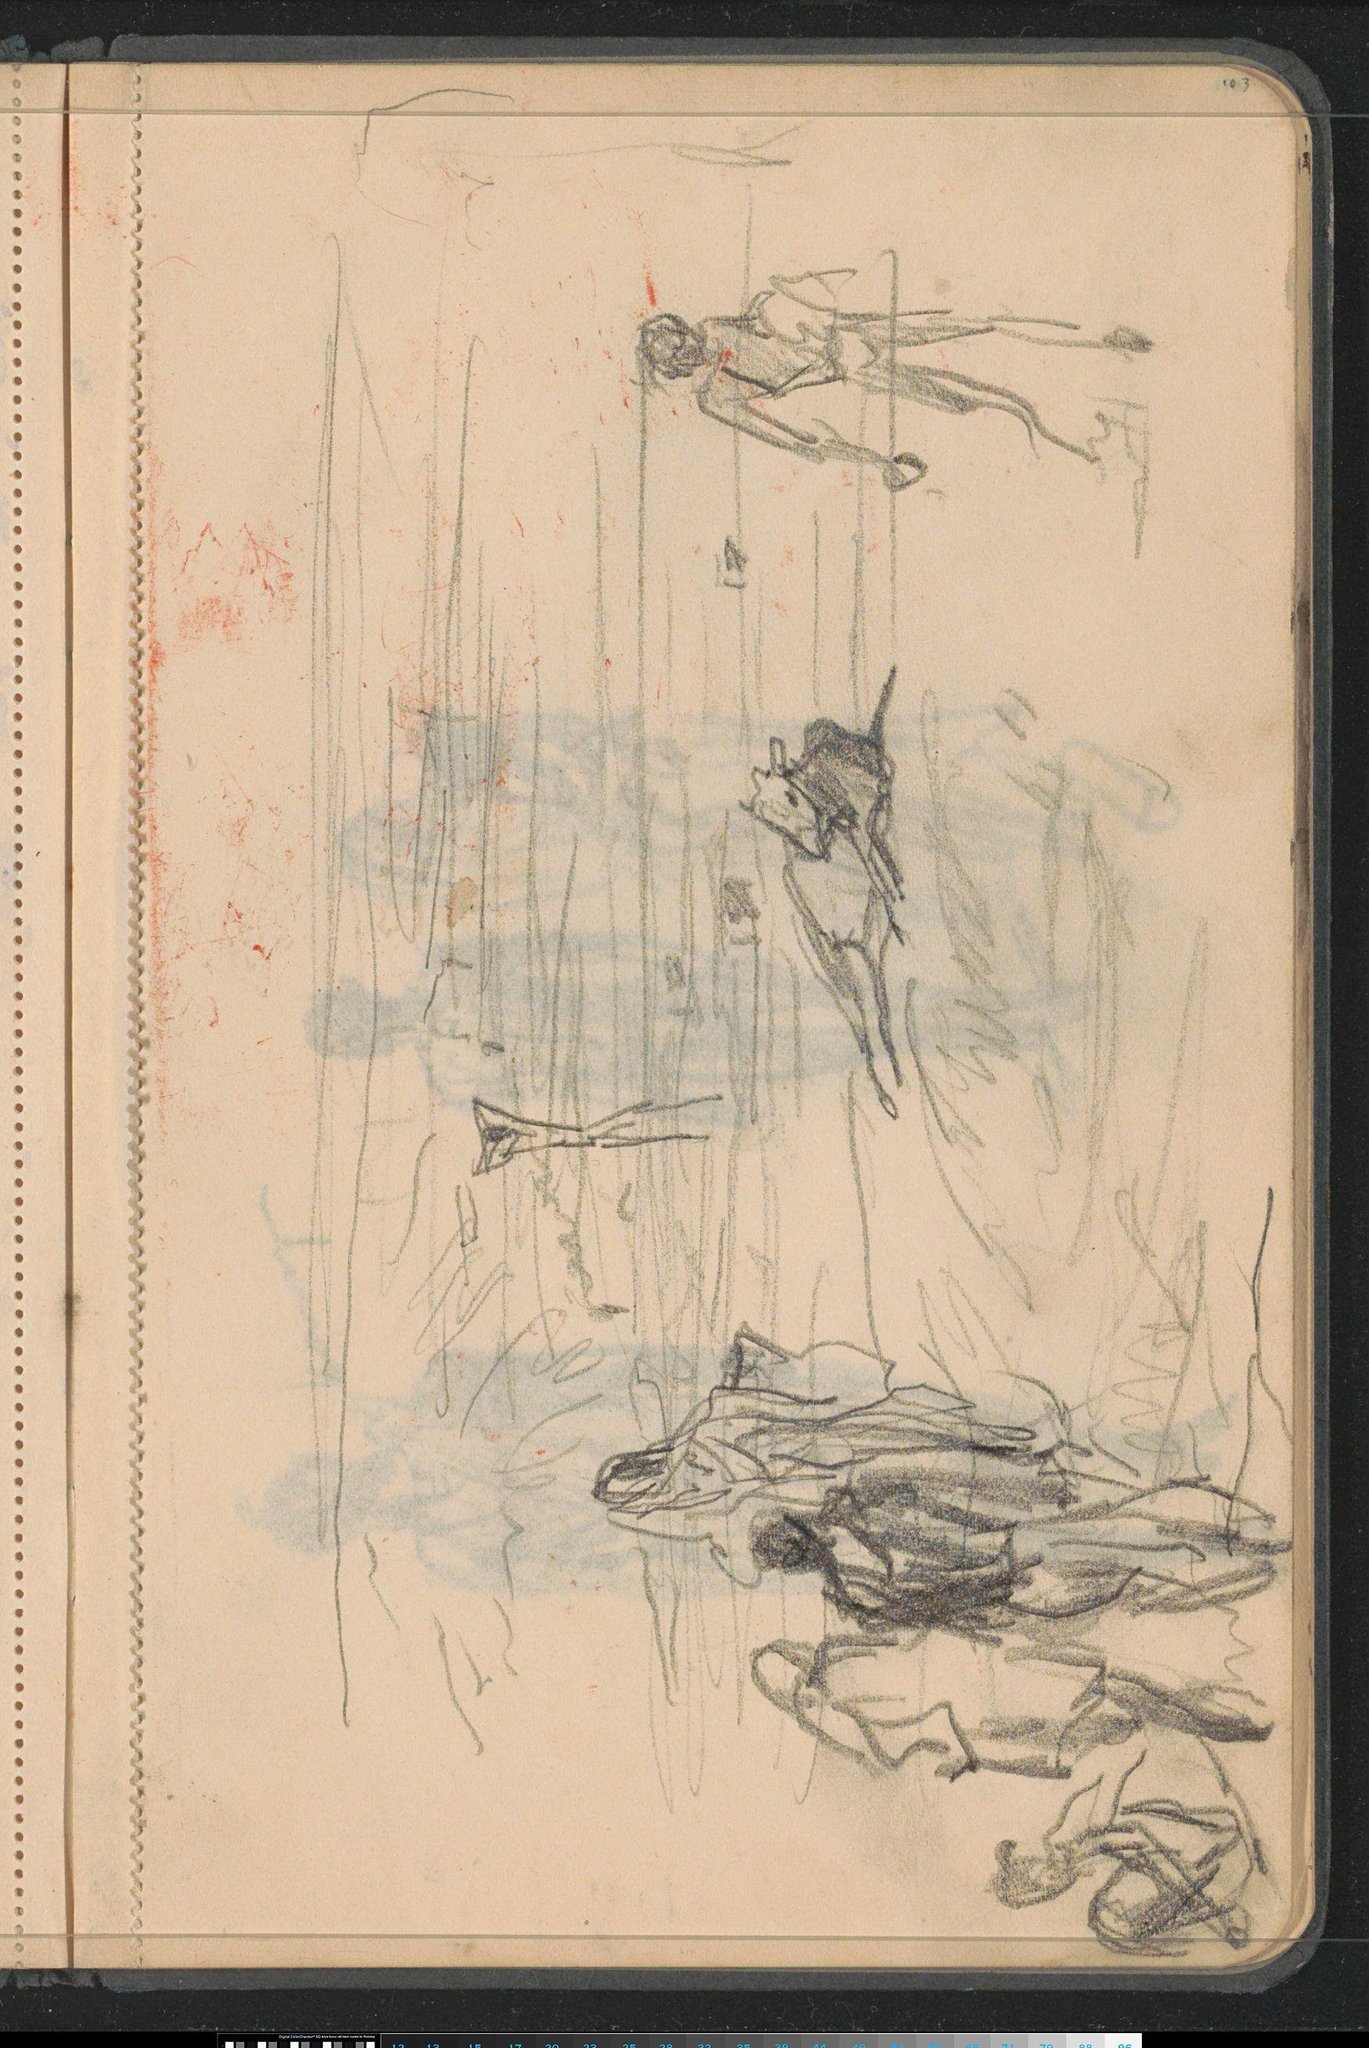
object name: sketchbook leaf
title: Groep Indiërs bij een liggende koe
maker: marius bauer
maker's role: draughtsman, print maker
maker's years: 1867-1932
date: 1924-1925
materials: paper, pencil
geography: india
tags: cow, asiatic races and peoples: indians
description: Pagina 103 uit een schetsboek met 87 bladen.